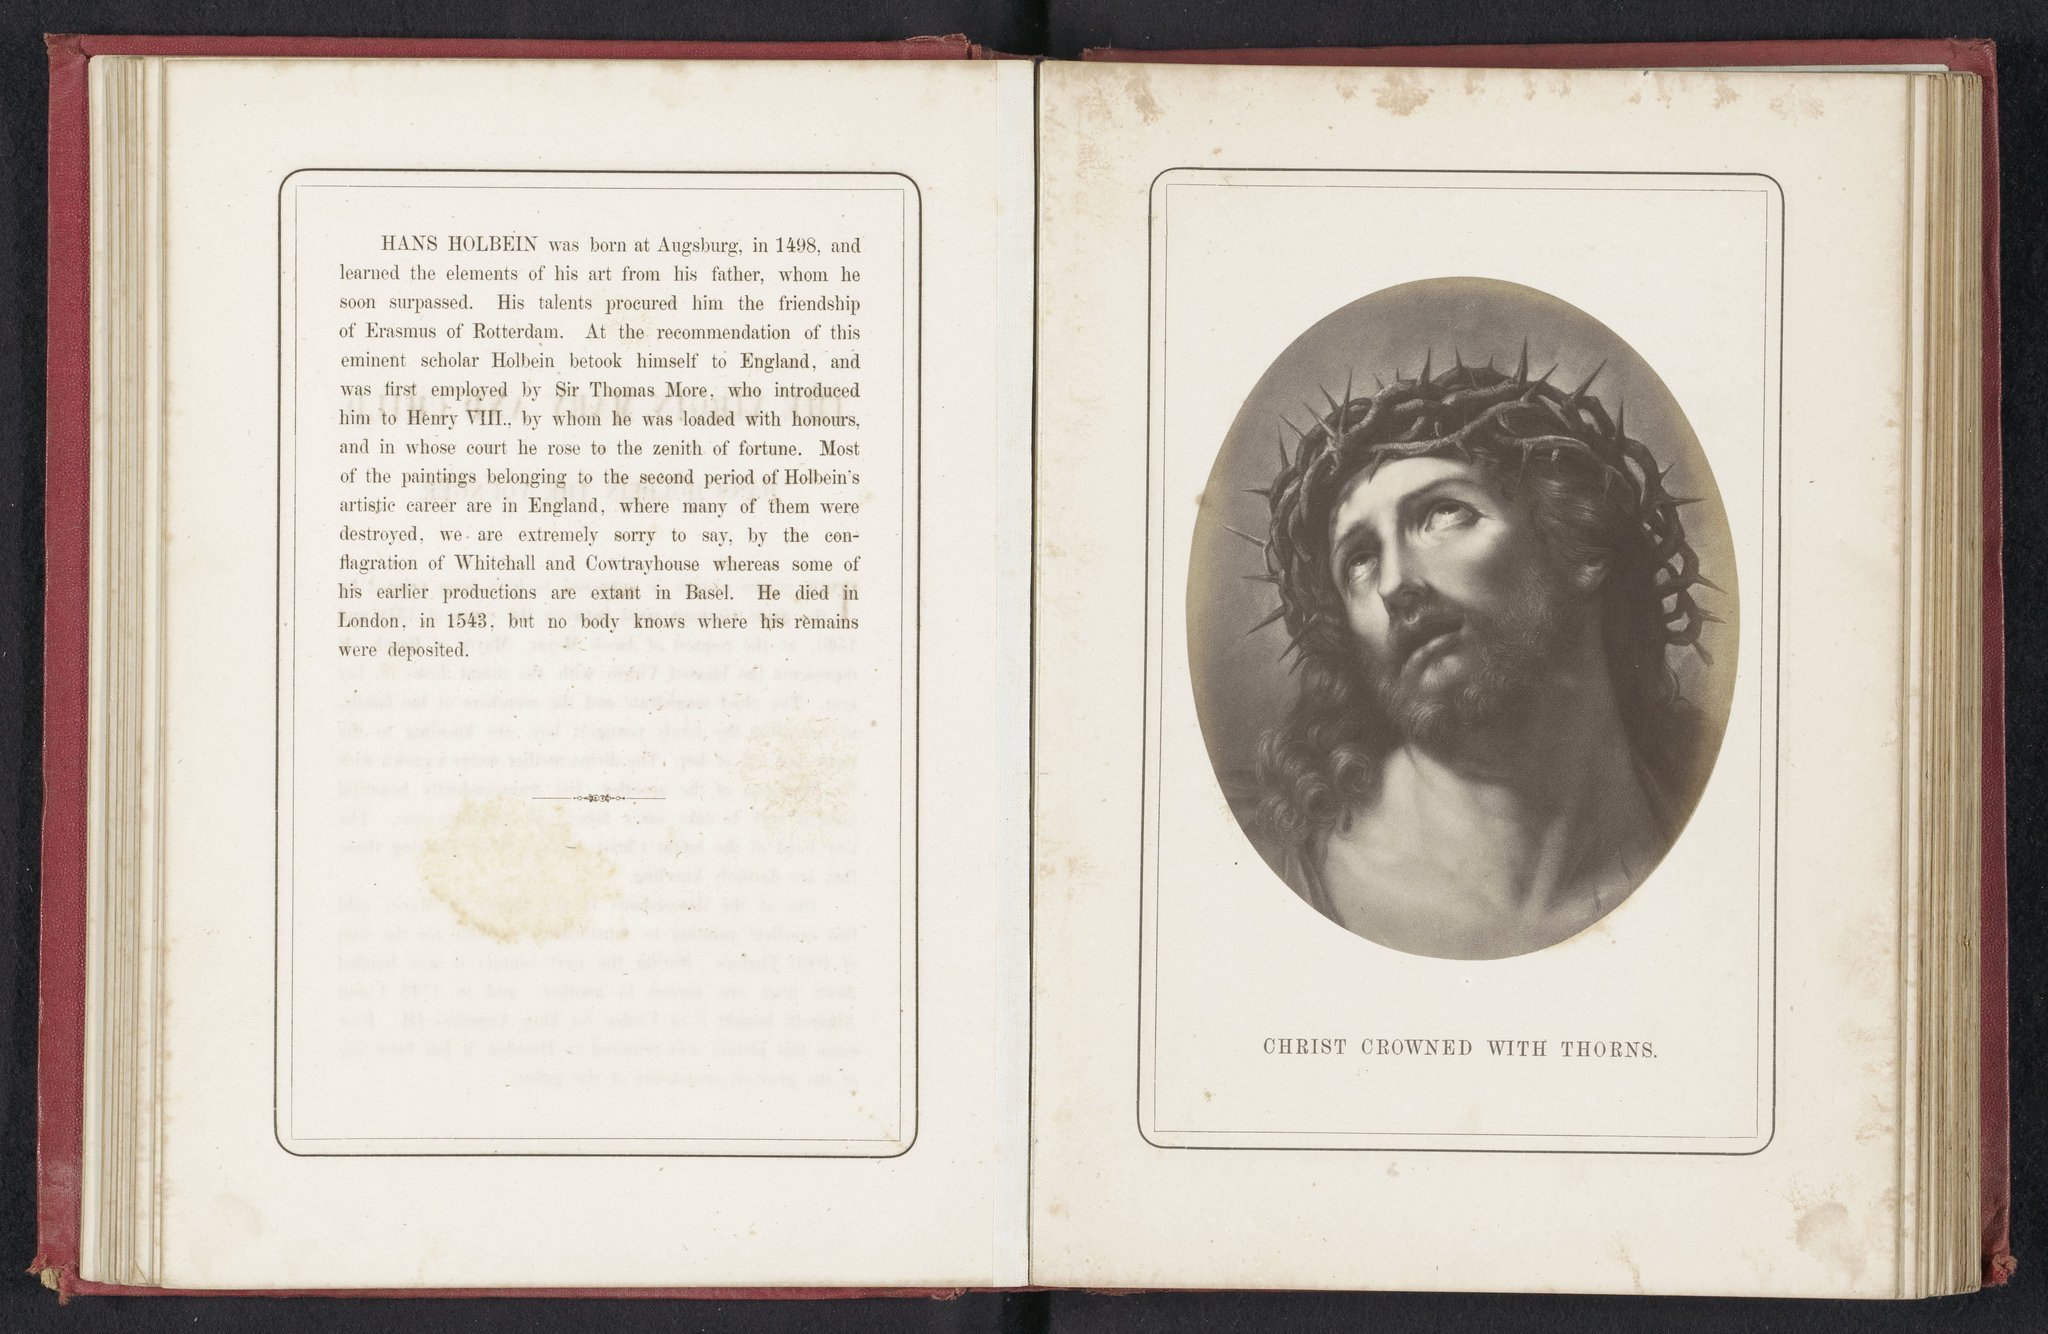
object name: page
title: Christ Crowned with Thorn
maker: hanns hanfstaengl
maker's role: print maker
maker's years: 1820-1885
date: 1854-1864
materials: photographic support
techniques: albumen print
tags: crown of thorns ~ instruments of the passion, picture, painting